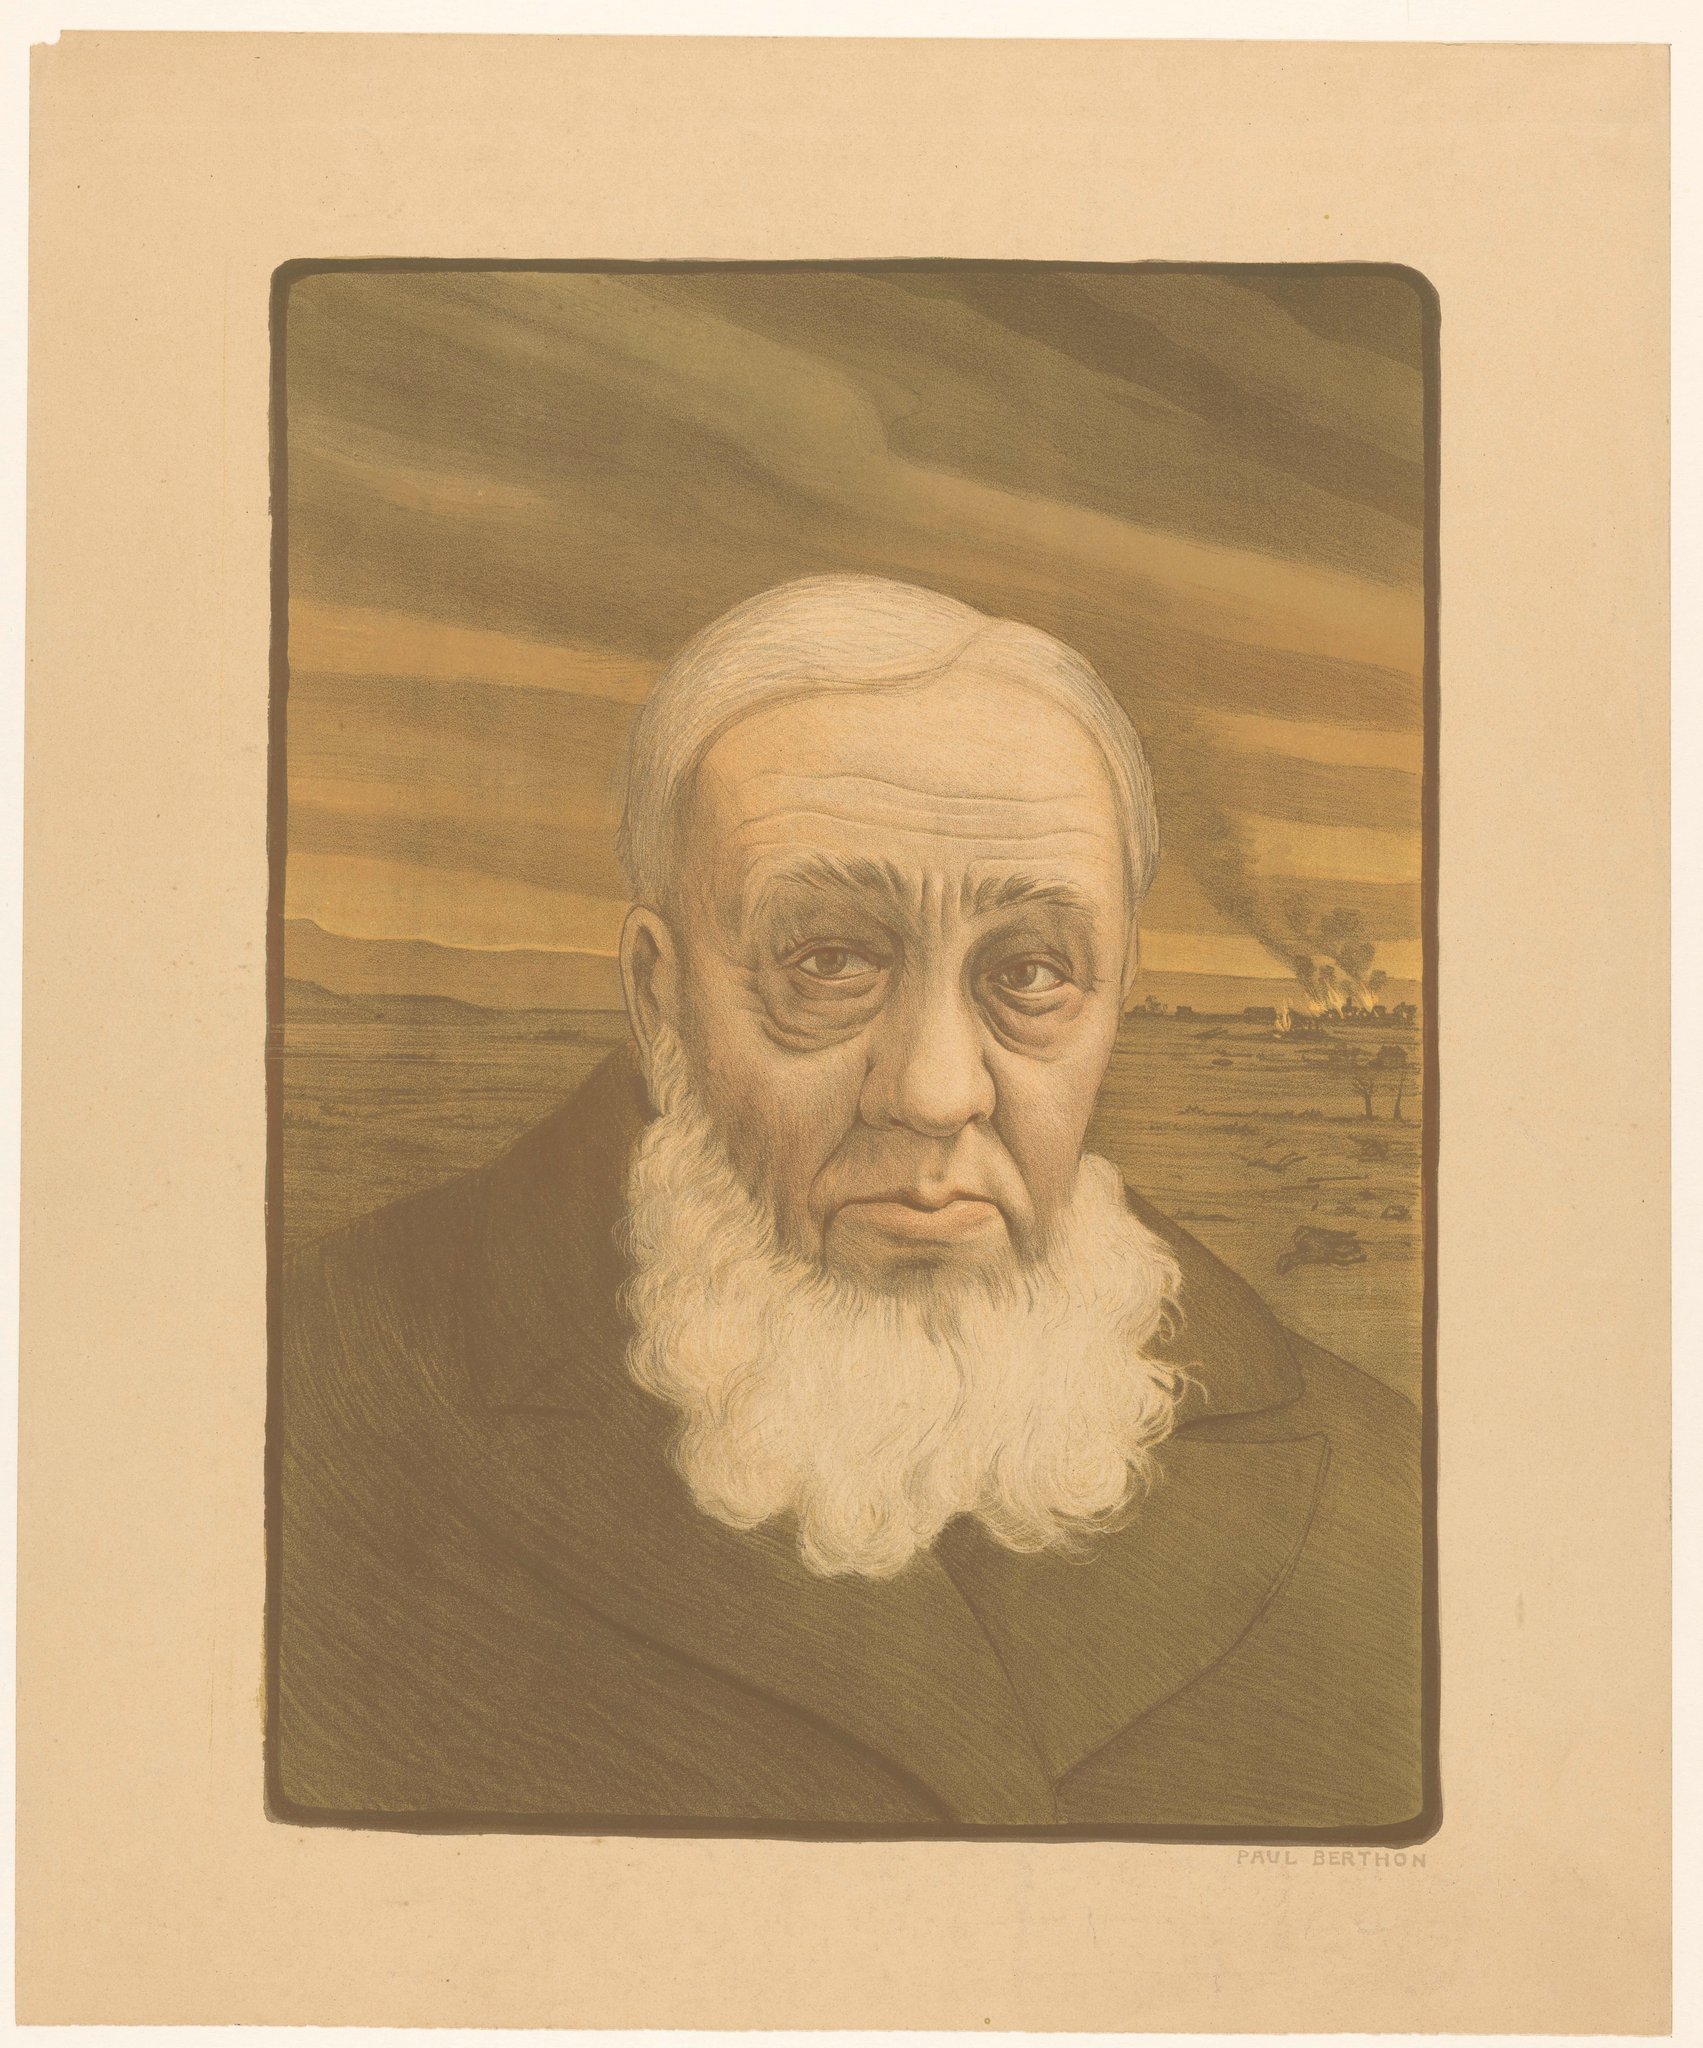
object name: print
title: Portret van Paul Kruger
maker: paul berthon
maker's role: print maker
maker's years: 1872-1909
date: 1882-1909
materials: paper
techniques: lithograph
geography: paris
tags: historical persons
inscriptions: collector's mark: Lugt 2228, collector's mark: Lugt 2760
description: Paul Kruger met op de achtergrond een brandend dorp in een Zuid-Afrikaans landschap.